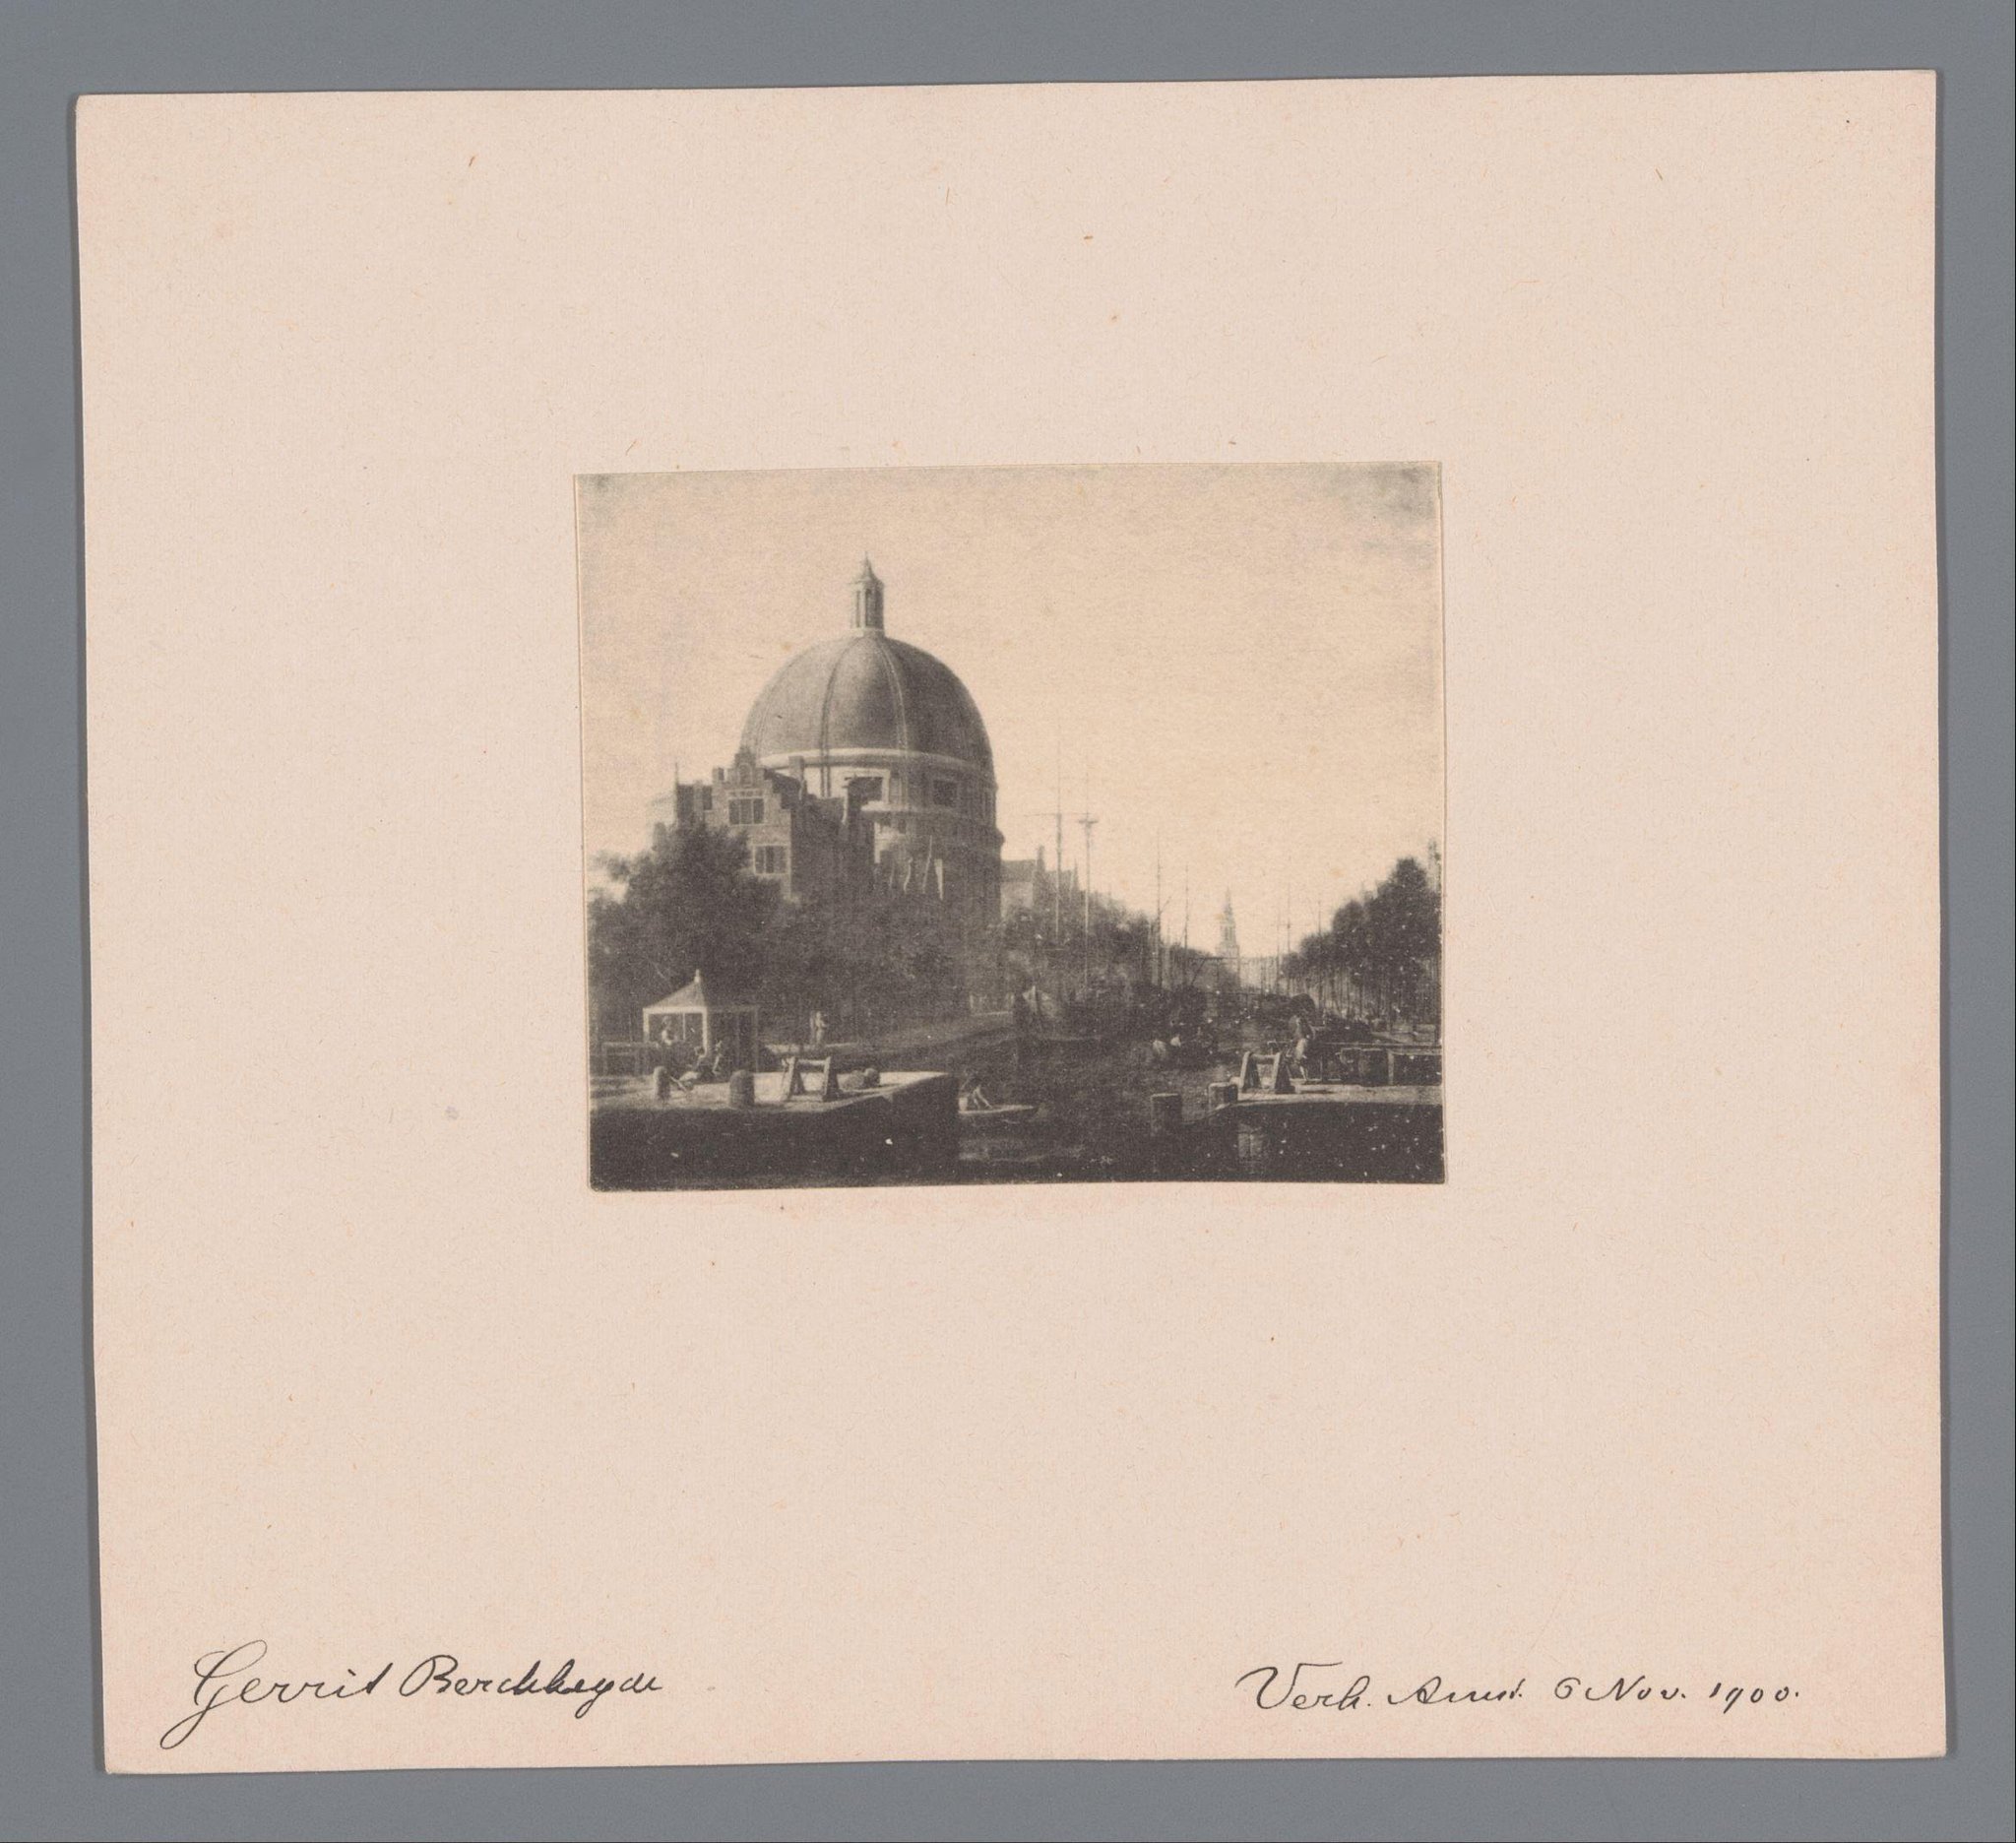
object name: reproduction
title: Reproductie van een schilderij van een gezicht op de Lutherse of Ronde Kerk te Amsterdam door Gerrit Adriaensz. Berckheyde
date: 1875-1900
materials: cardboard, paper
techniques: photograph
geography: amsterdam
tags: city-view in general; 'veduta', canals, waters (in city), amsterdam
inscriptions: annotation: ‘Gerrit Berckheyde/ erk. Amst. 6 Nov. 1900’